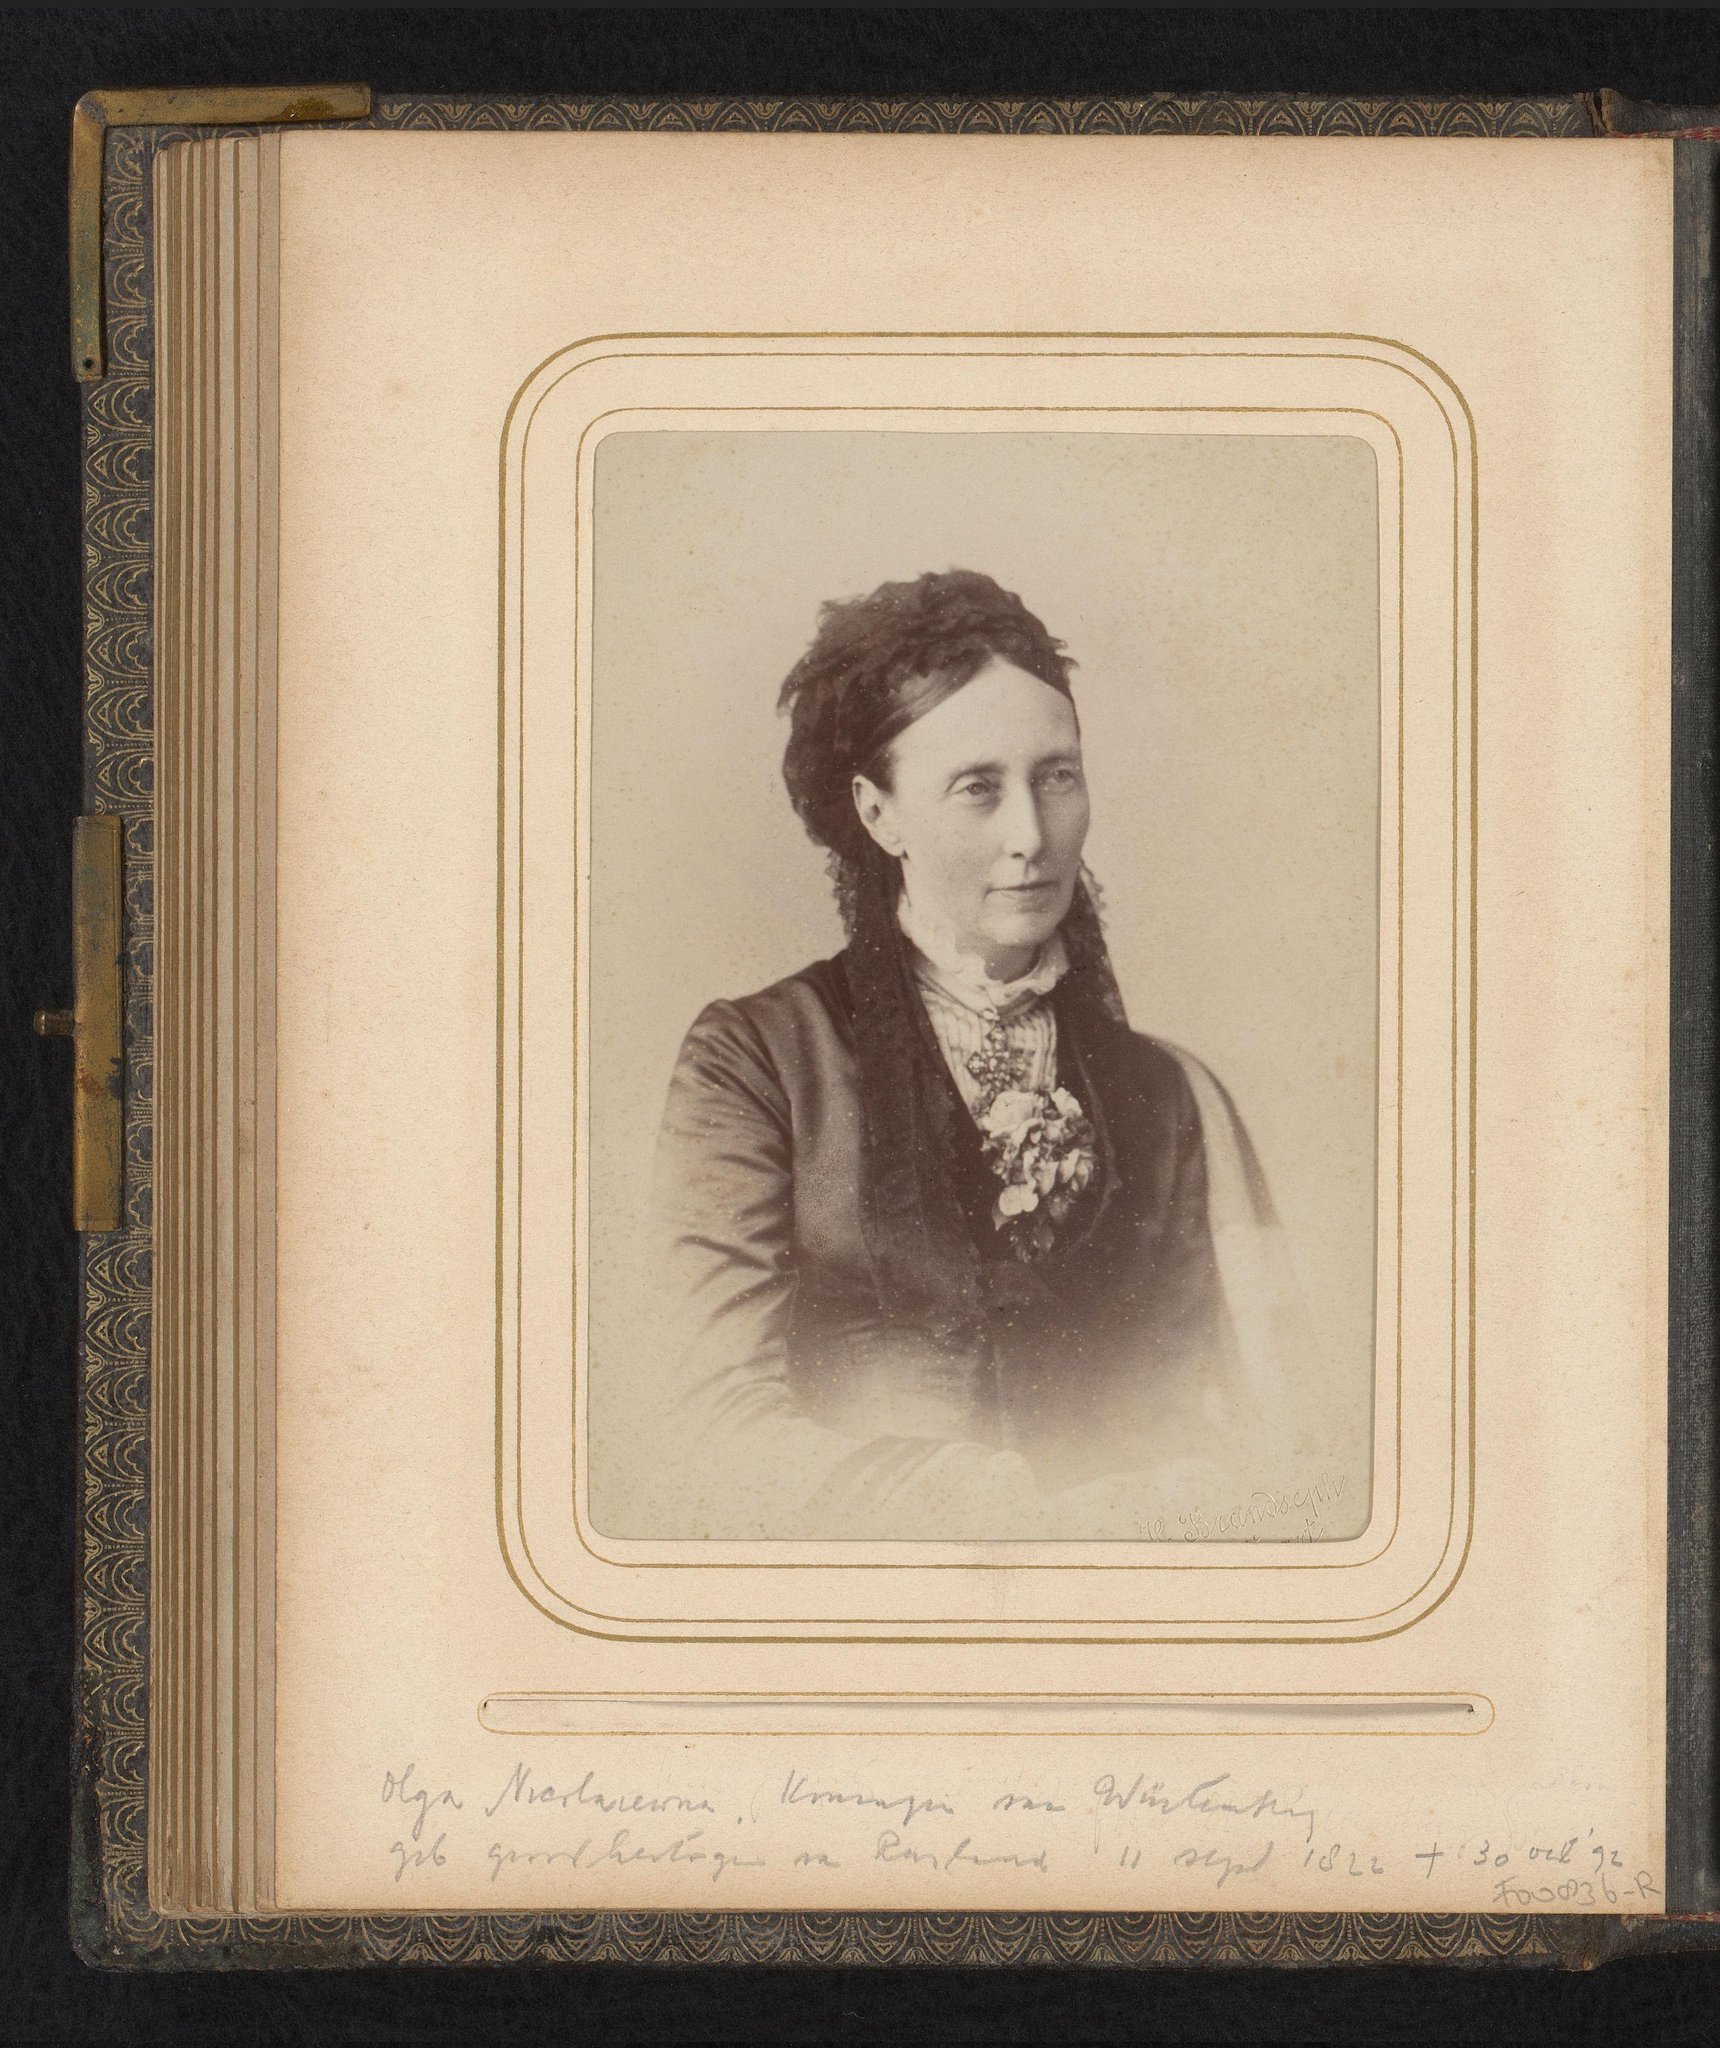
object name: album leaf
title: Portret van Olga Nikolajevna, grootvorstin van Rusland, koningin van Württemberg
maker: hermann brandseph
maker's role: fotograaf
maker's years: 1826-1915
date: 1890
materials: cardboard, photographic support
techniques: gelatin silver print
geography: stuttgart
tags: historical persons - bb - woman, queen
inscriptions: annotation: ‘Koningin v. Würtenberg/ neé/ Olga Nicolaievna/ grand duchess de Russie/ Neé le 11 sept. 1822/ morte 30.10.92 (...)’, annotation: ‘Olga Nikolajevna, koningin van Würtenberg/ [...] groothertogin van Rusland 11 sept 1822 - 30 okt '92’, date: ‘1890’, inscription: ‘Hermann Brandseph/ Königl. Württ. Hofphotograph/ Stuttgart/ Marienstrasse 36. Telephon 426’